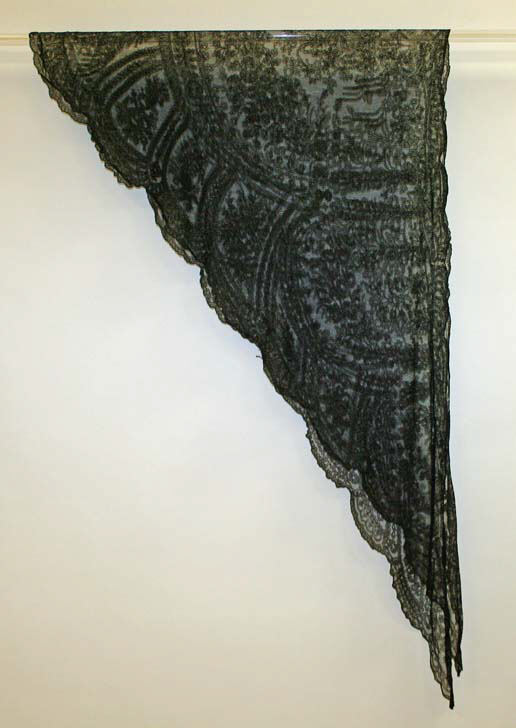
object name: shawl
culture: cuban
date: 1853